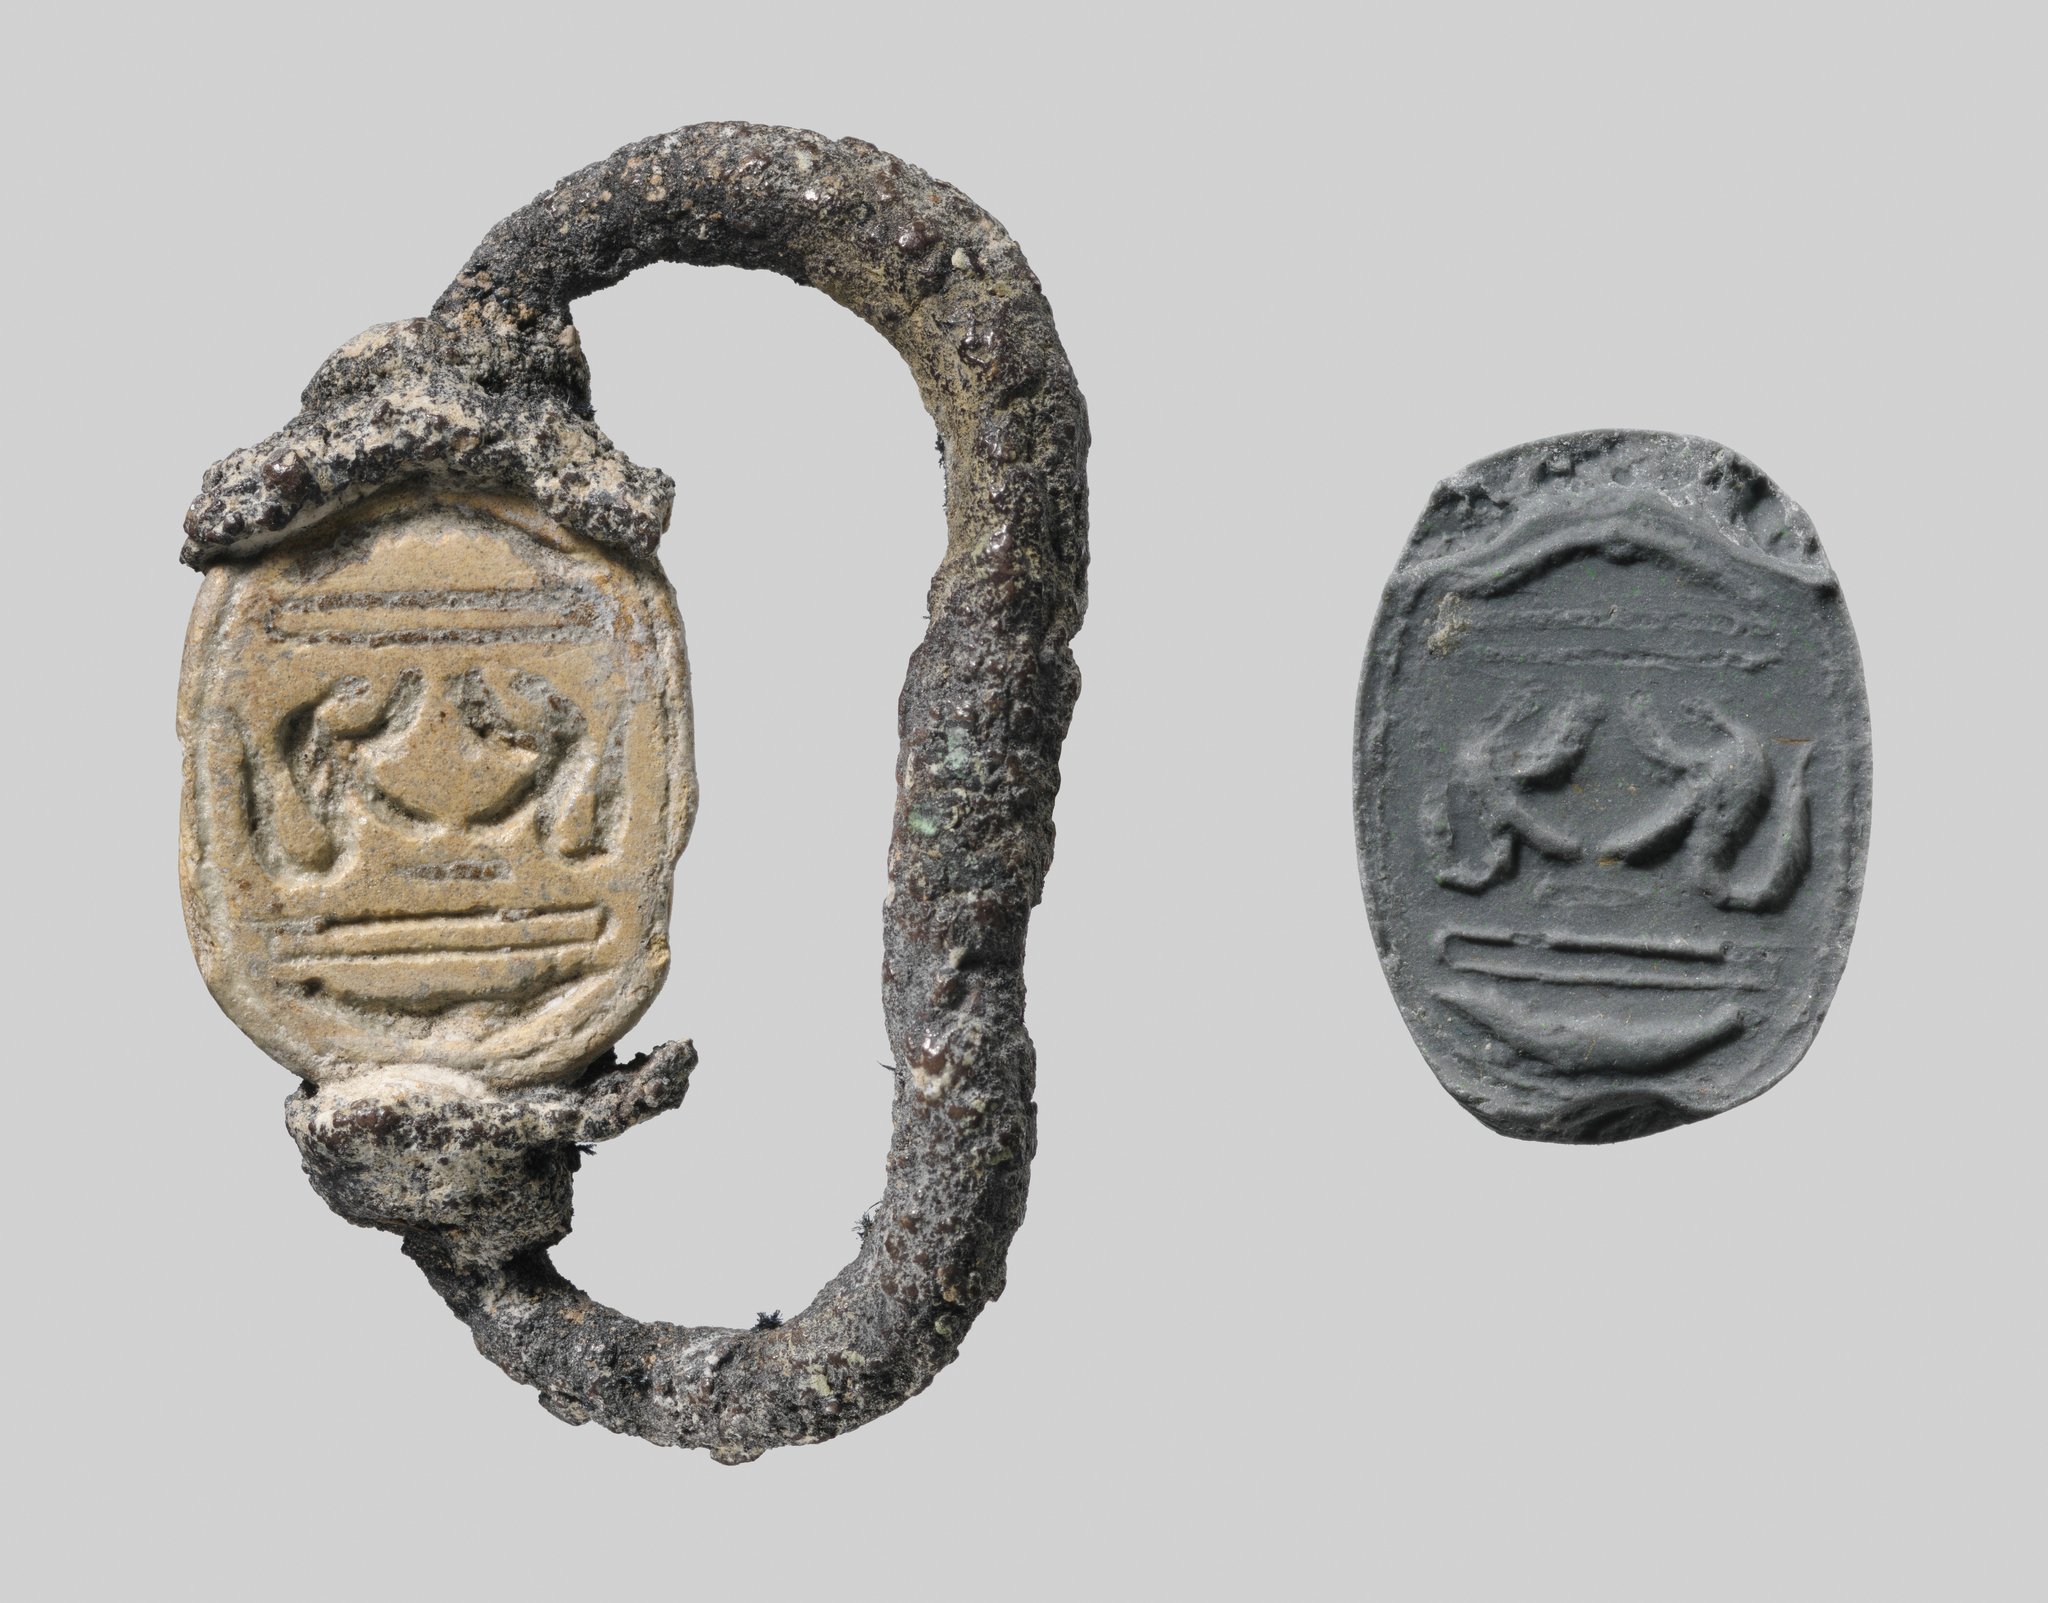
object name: ring, pendant, with scarab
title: Silver pendant ring with steatite scarab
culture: phoenician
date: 800-601 BCE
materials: silver, stone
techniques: glazing